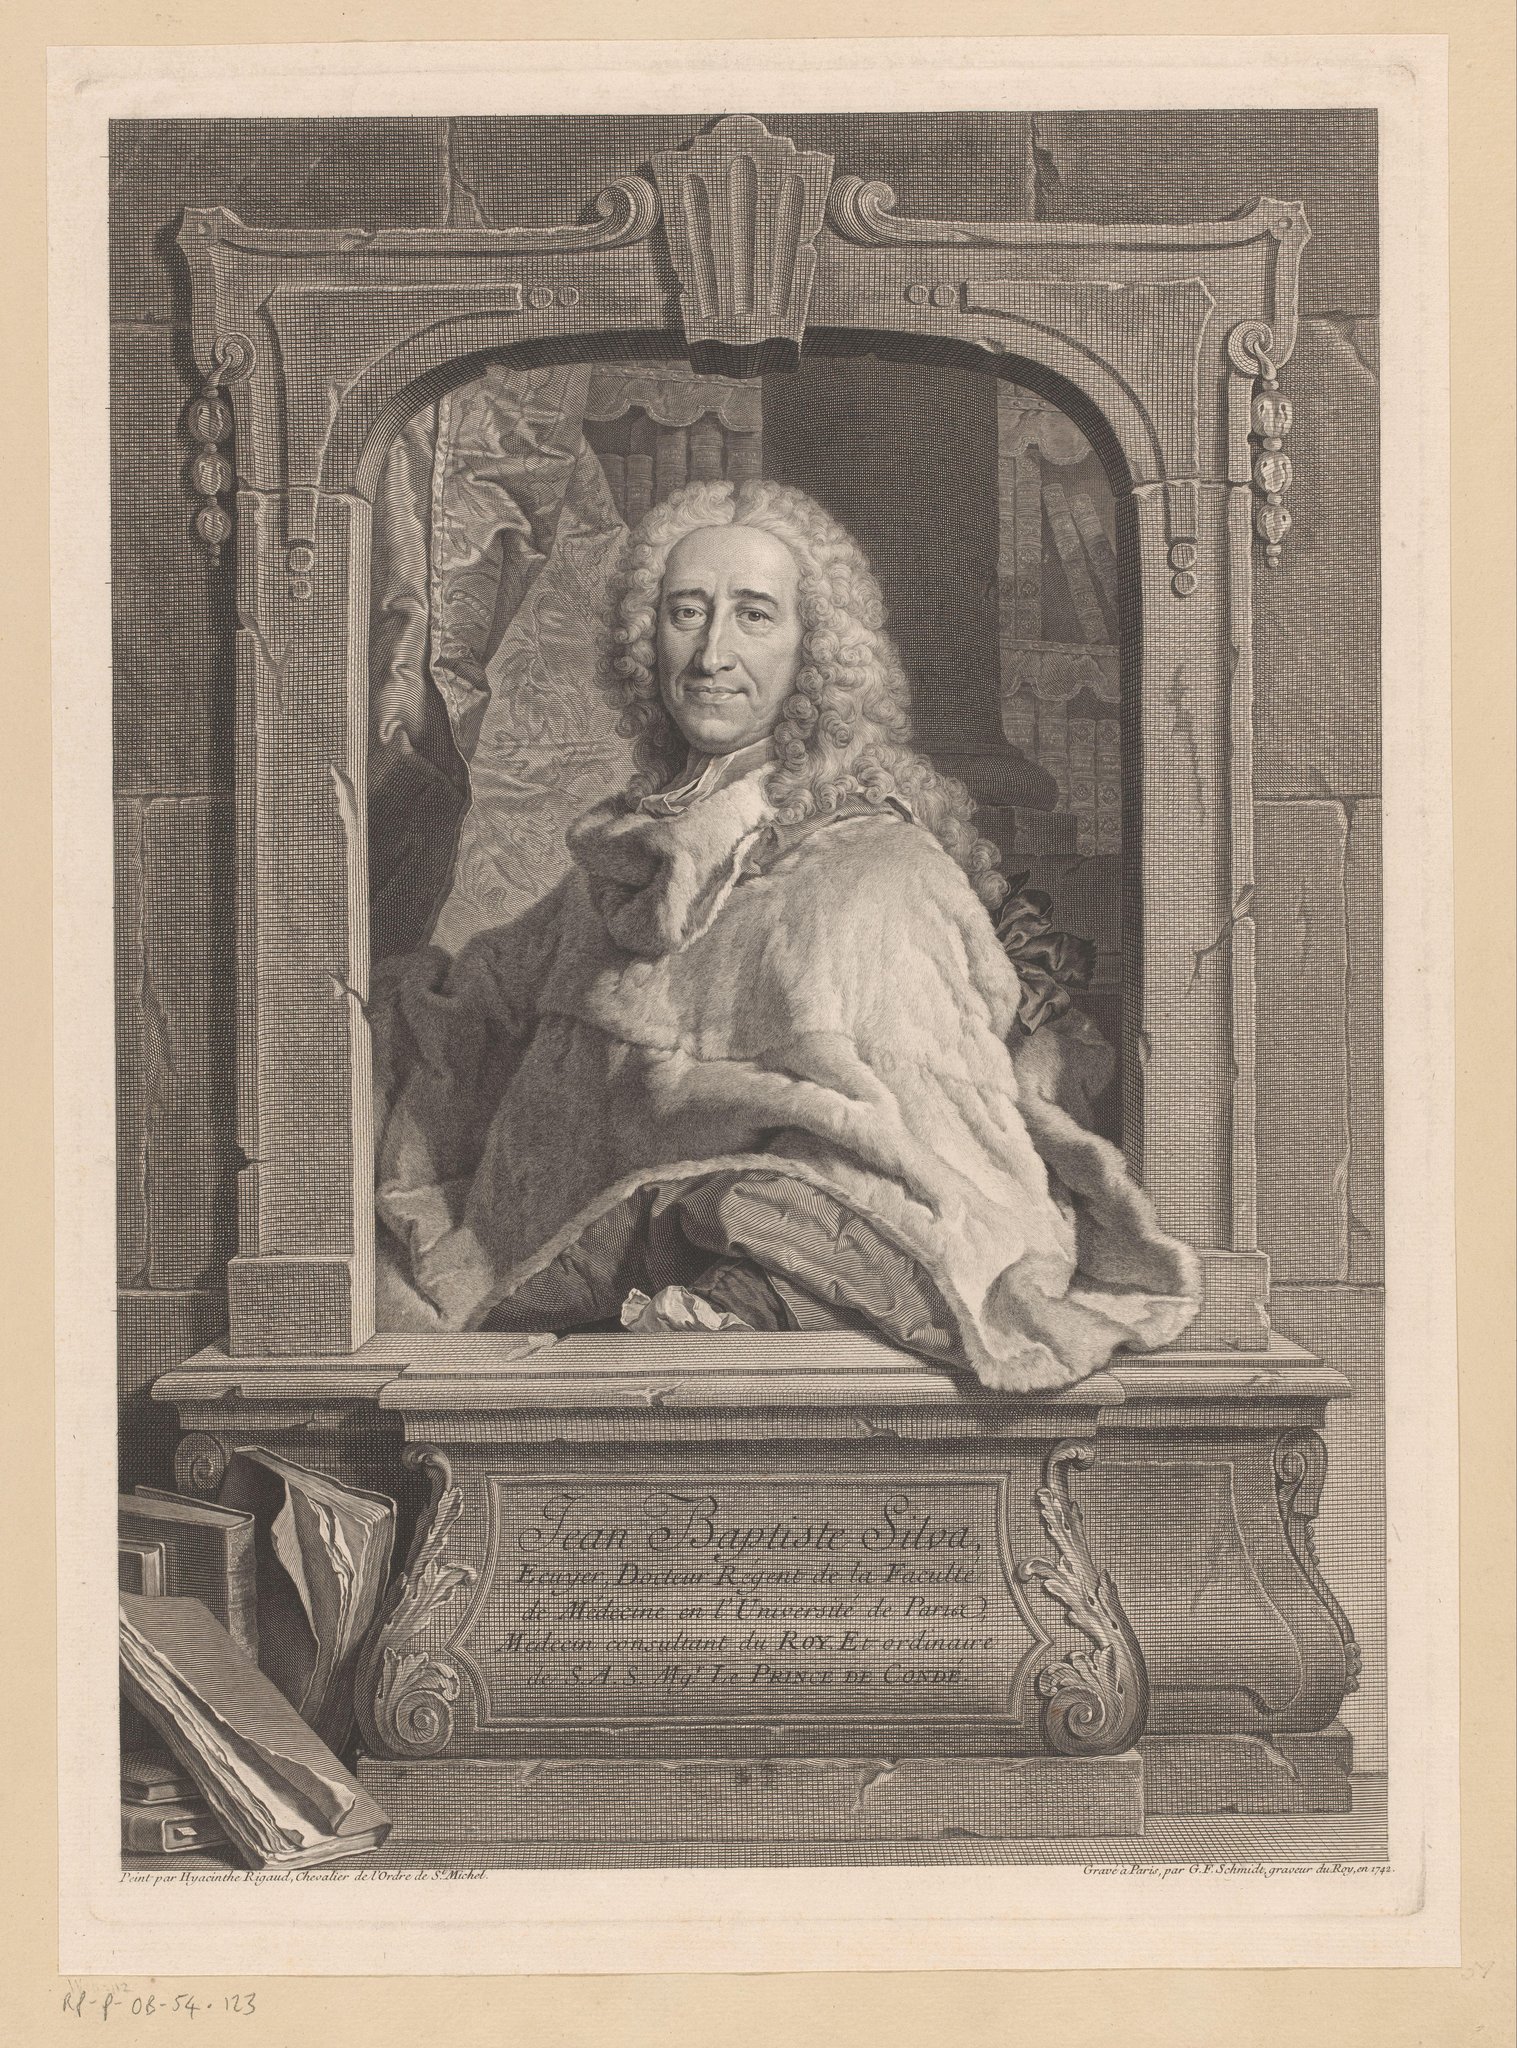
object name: print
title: Portret van Jean-Baptiste Silva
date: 1742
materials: paper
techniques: engraving, etching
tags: historical persons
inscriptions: collector's mark: Lugt 240